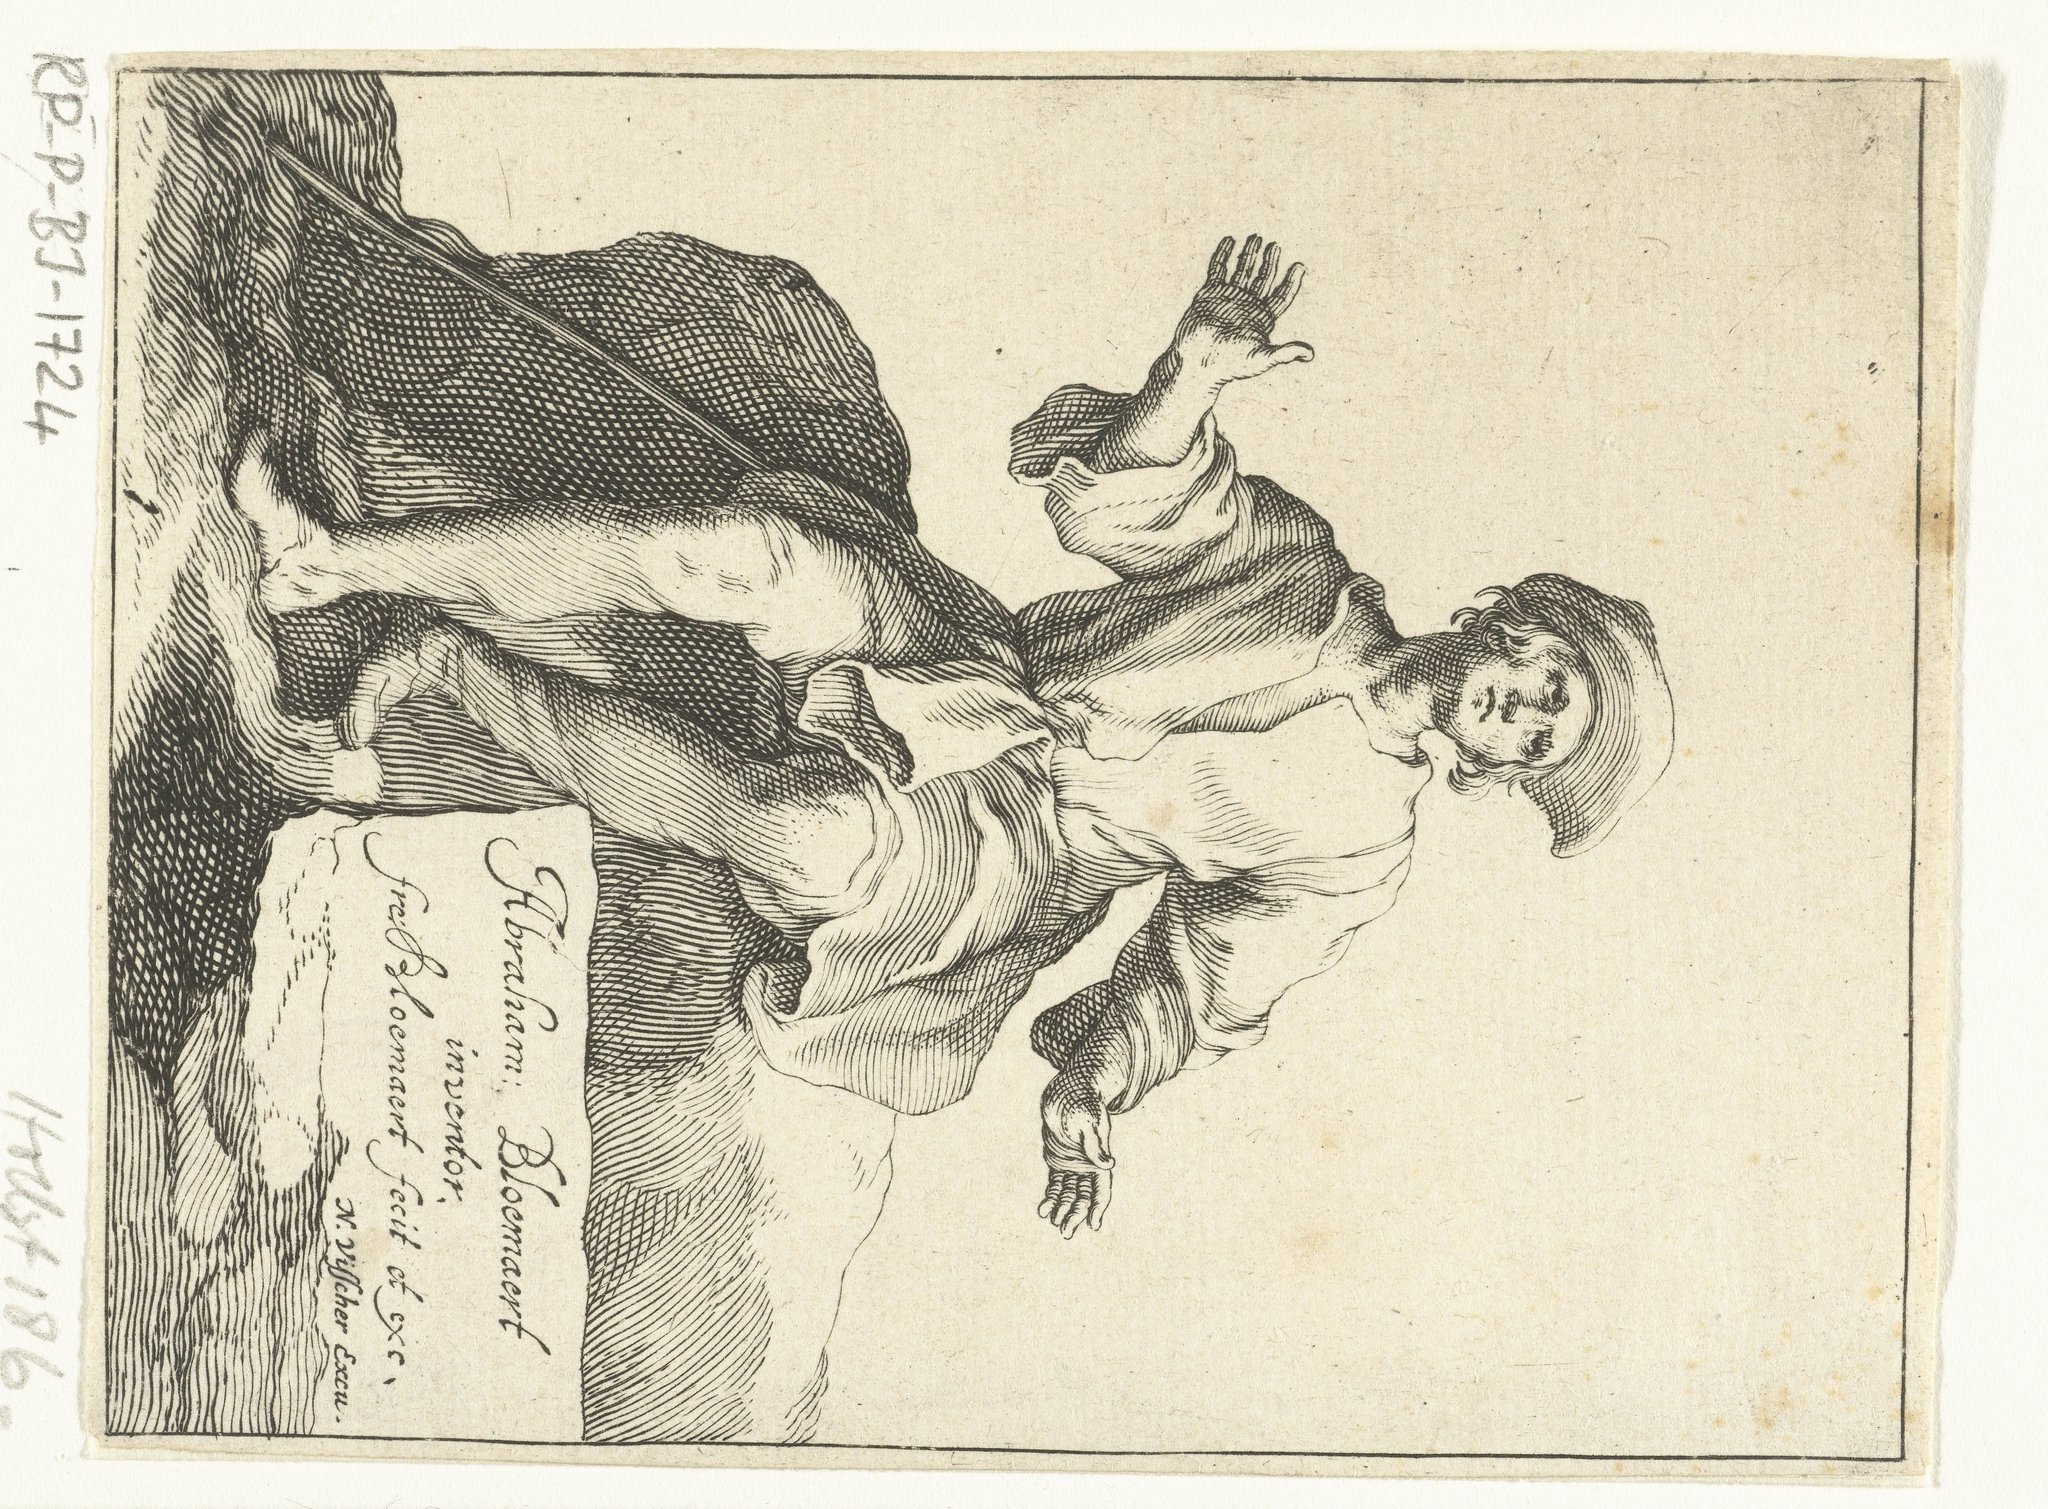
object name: titelprent, frontispice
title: Zittende man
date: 1635-1669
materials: paper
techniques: engraving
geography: amsterdam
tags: farmers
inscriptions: collector's mark: Lugt 240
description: Een man zit op een rotsblok, een stok naast hem, de ogen wat opgeslagen naar boven.